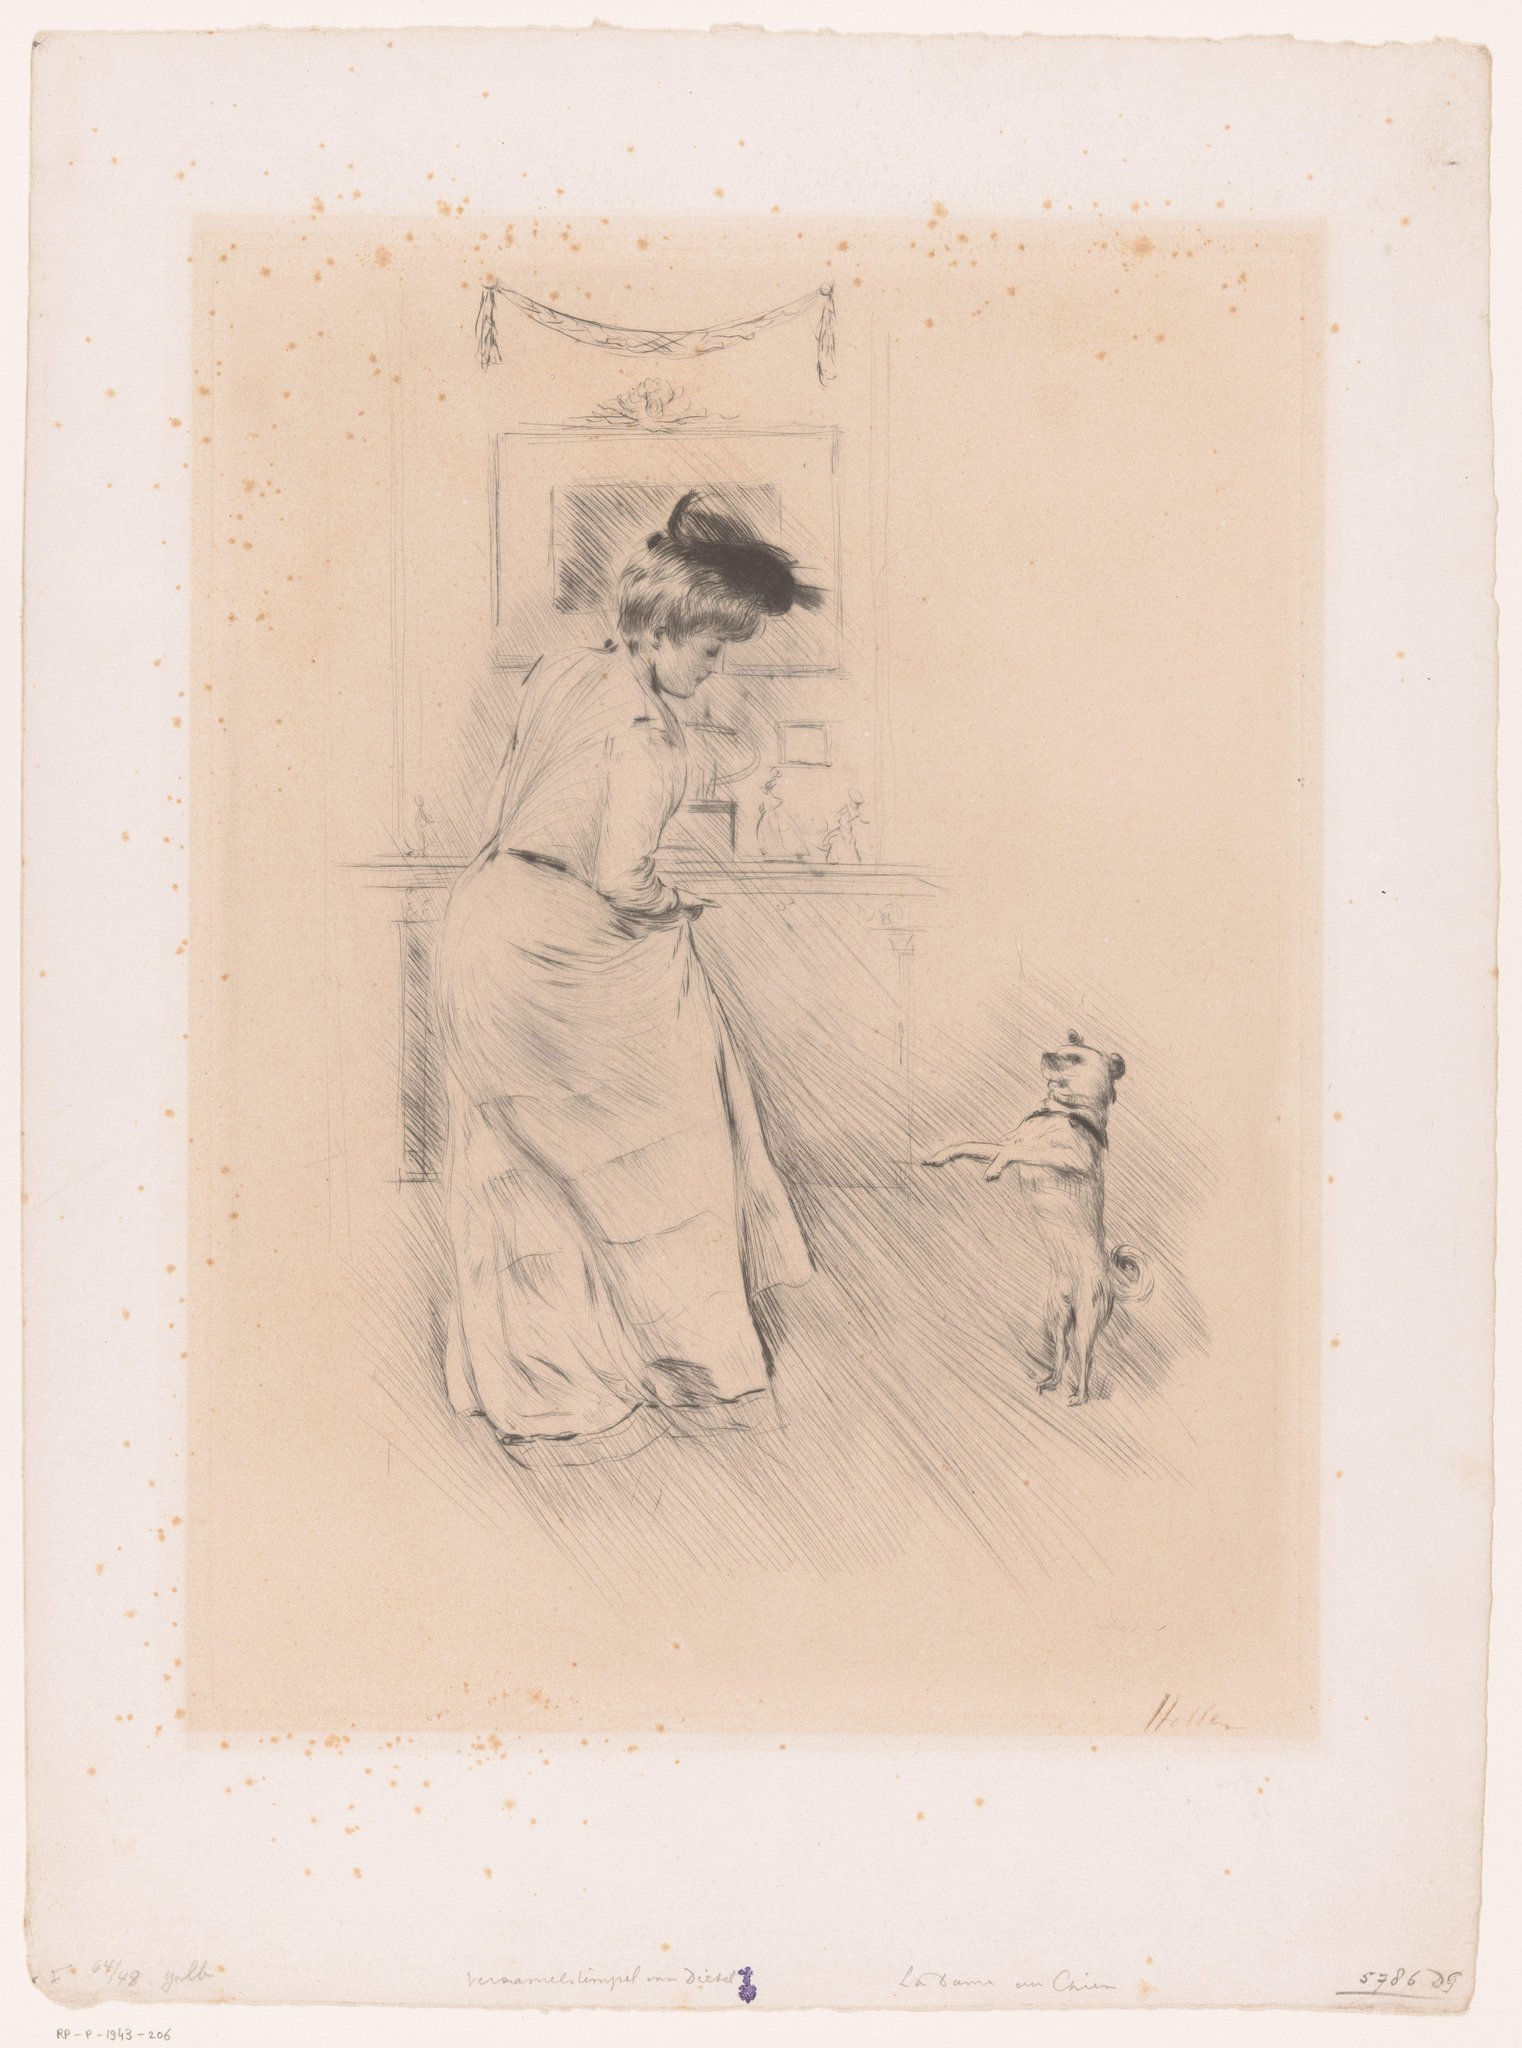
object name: print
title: Jonge vrouw met hond voor een schoorsteenmantel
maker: paul césar helleu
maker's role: draughtsman, painter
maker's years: 1859-1927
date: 1900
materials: paper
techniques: drypoint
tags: adolescent, young woman, maiden, chimney-piece, mantelpiece, dog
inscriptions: stamp: Lugt 2722b, collector's mark: Lugt 2228, collector's mark: Lugt 2760